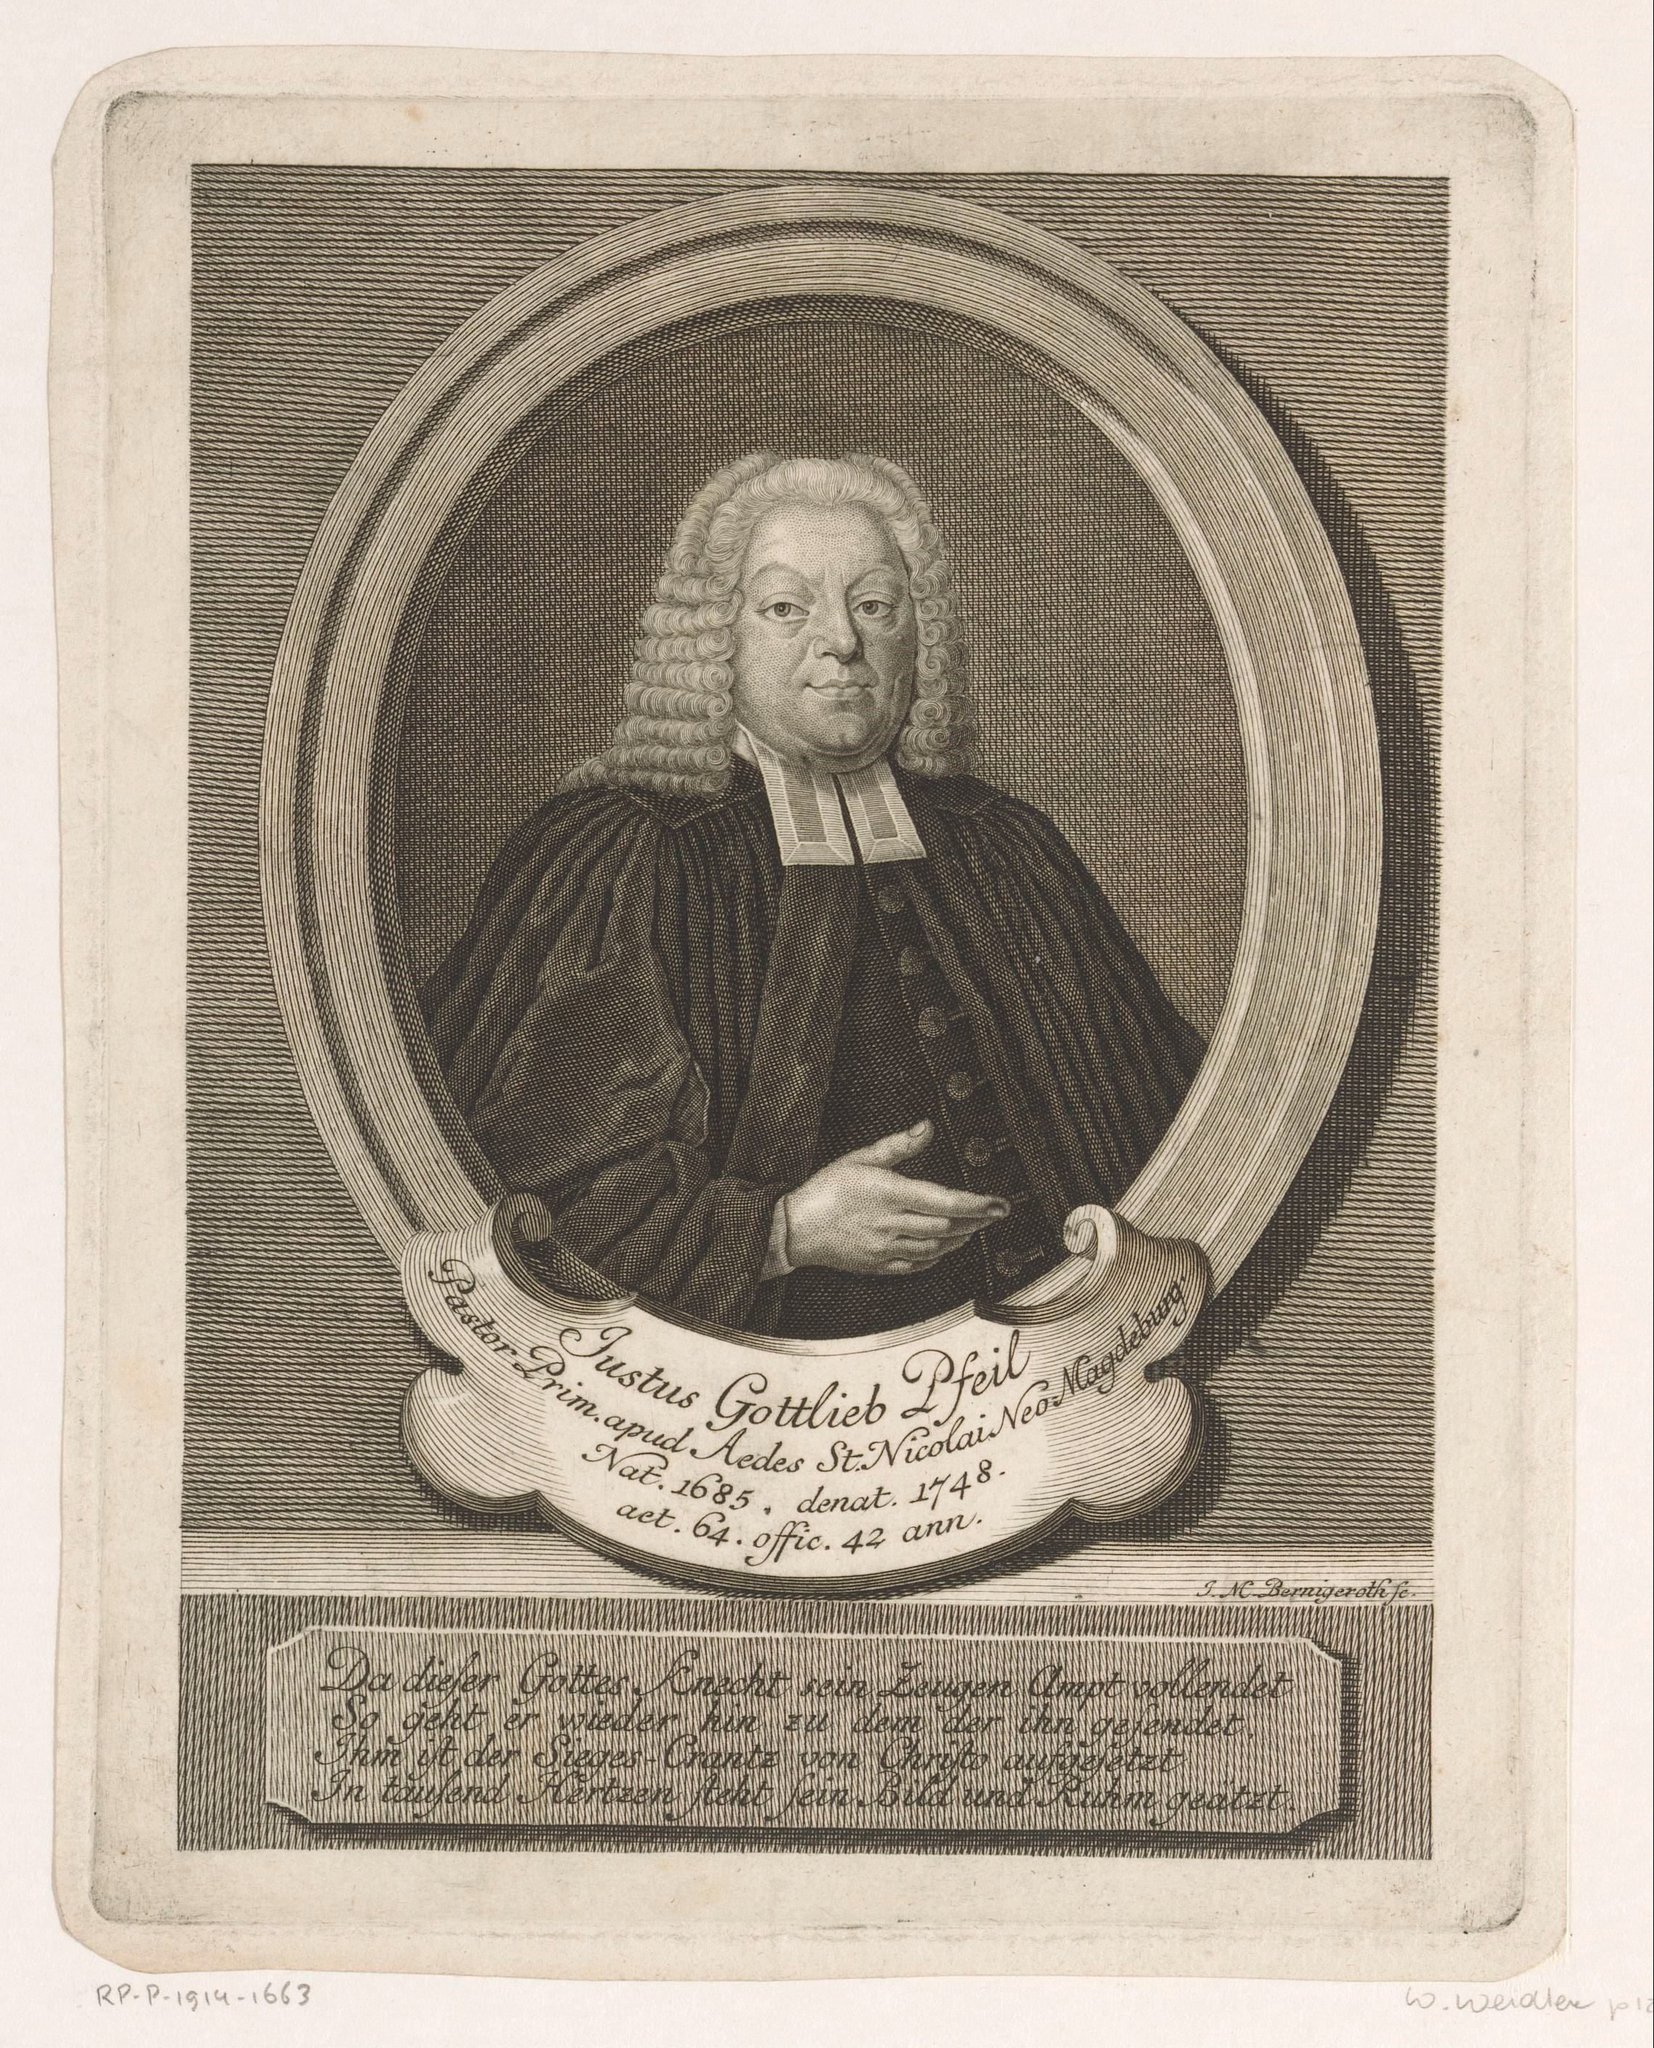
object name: print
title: Portret van Justus Gottlieb Pfeil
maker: johann martin bernigeroth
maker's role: print maker, publisher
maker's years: 1713-1767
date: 1748-1767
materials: paper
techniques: engraving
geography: leipzig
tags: historical persons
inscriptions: collector's mark: Lugt 2228